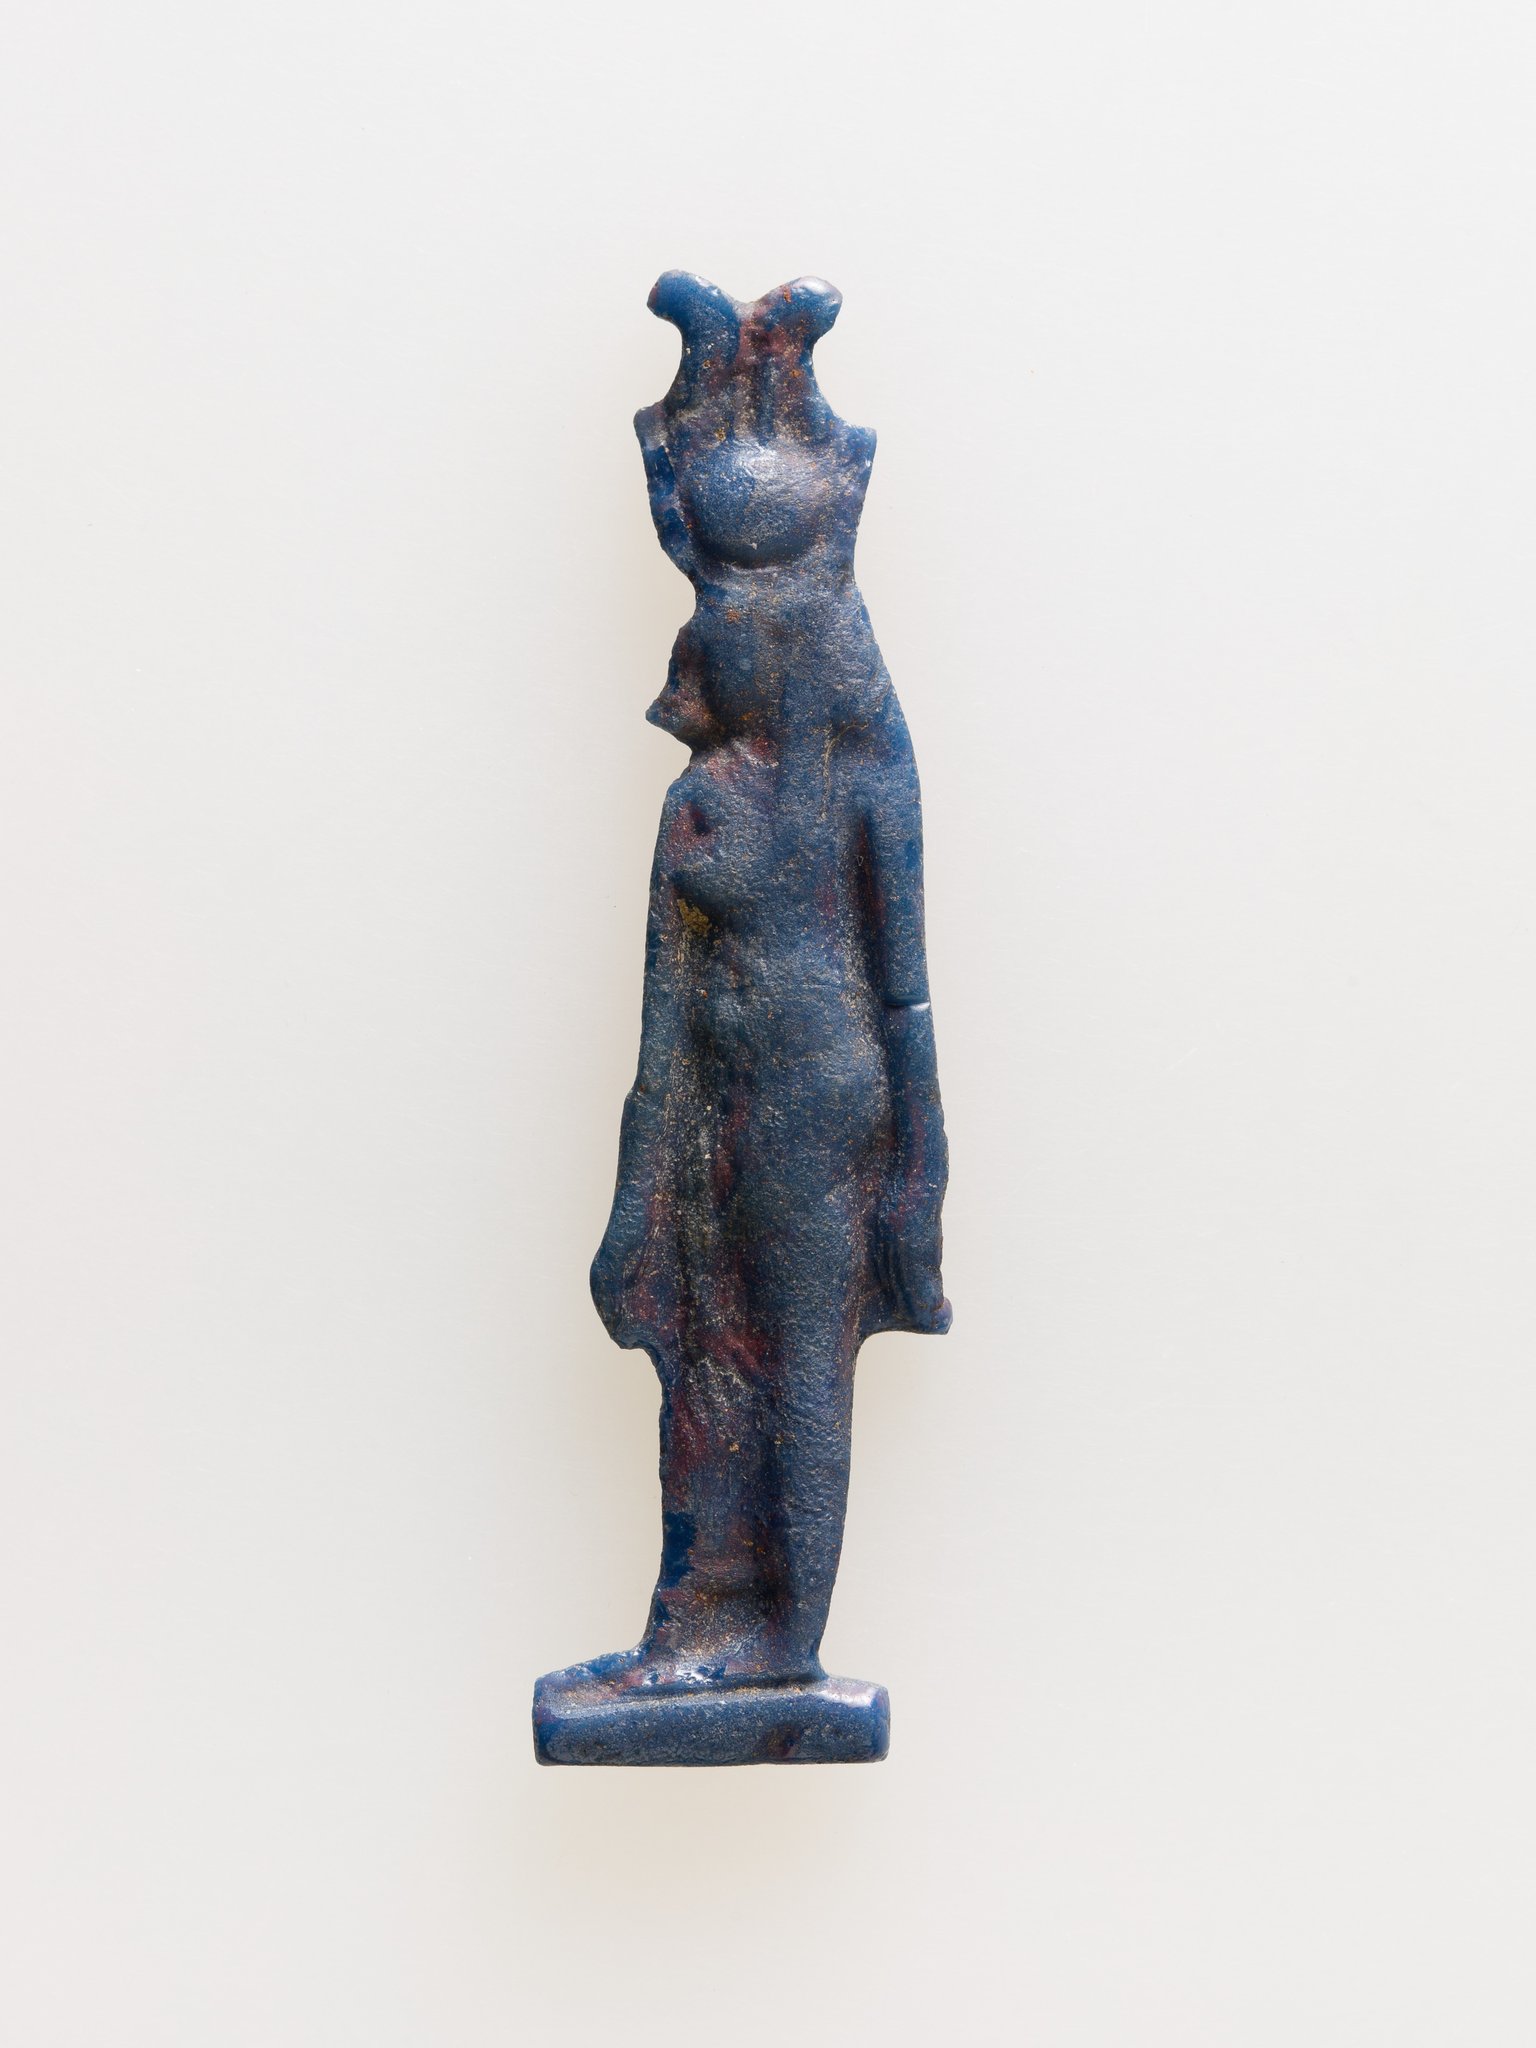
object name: amulet, cow headed goddess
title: Amulet of cow-headed goddess with feathers atop disk and horns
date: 525-30 BCE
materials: glass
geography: egypt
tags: goddess